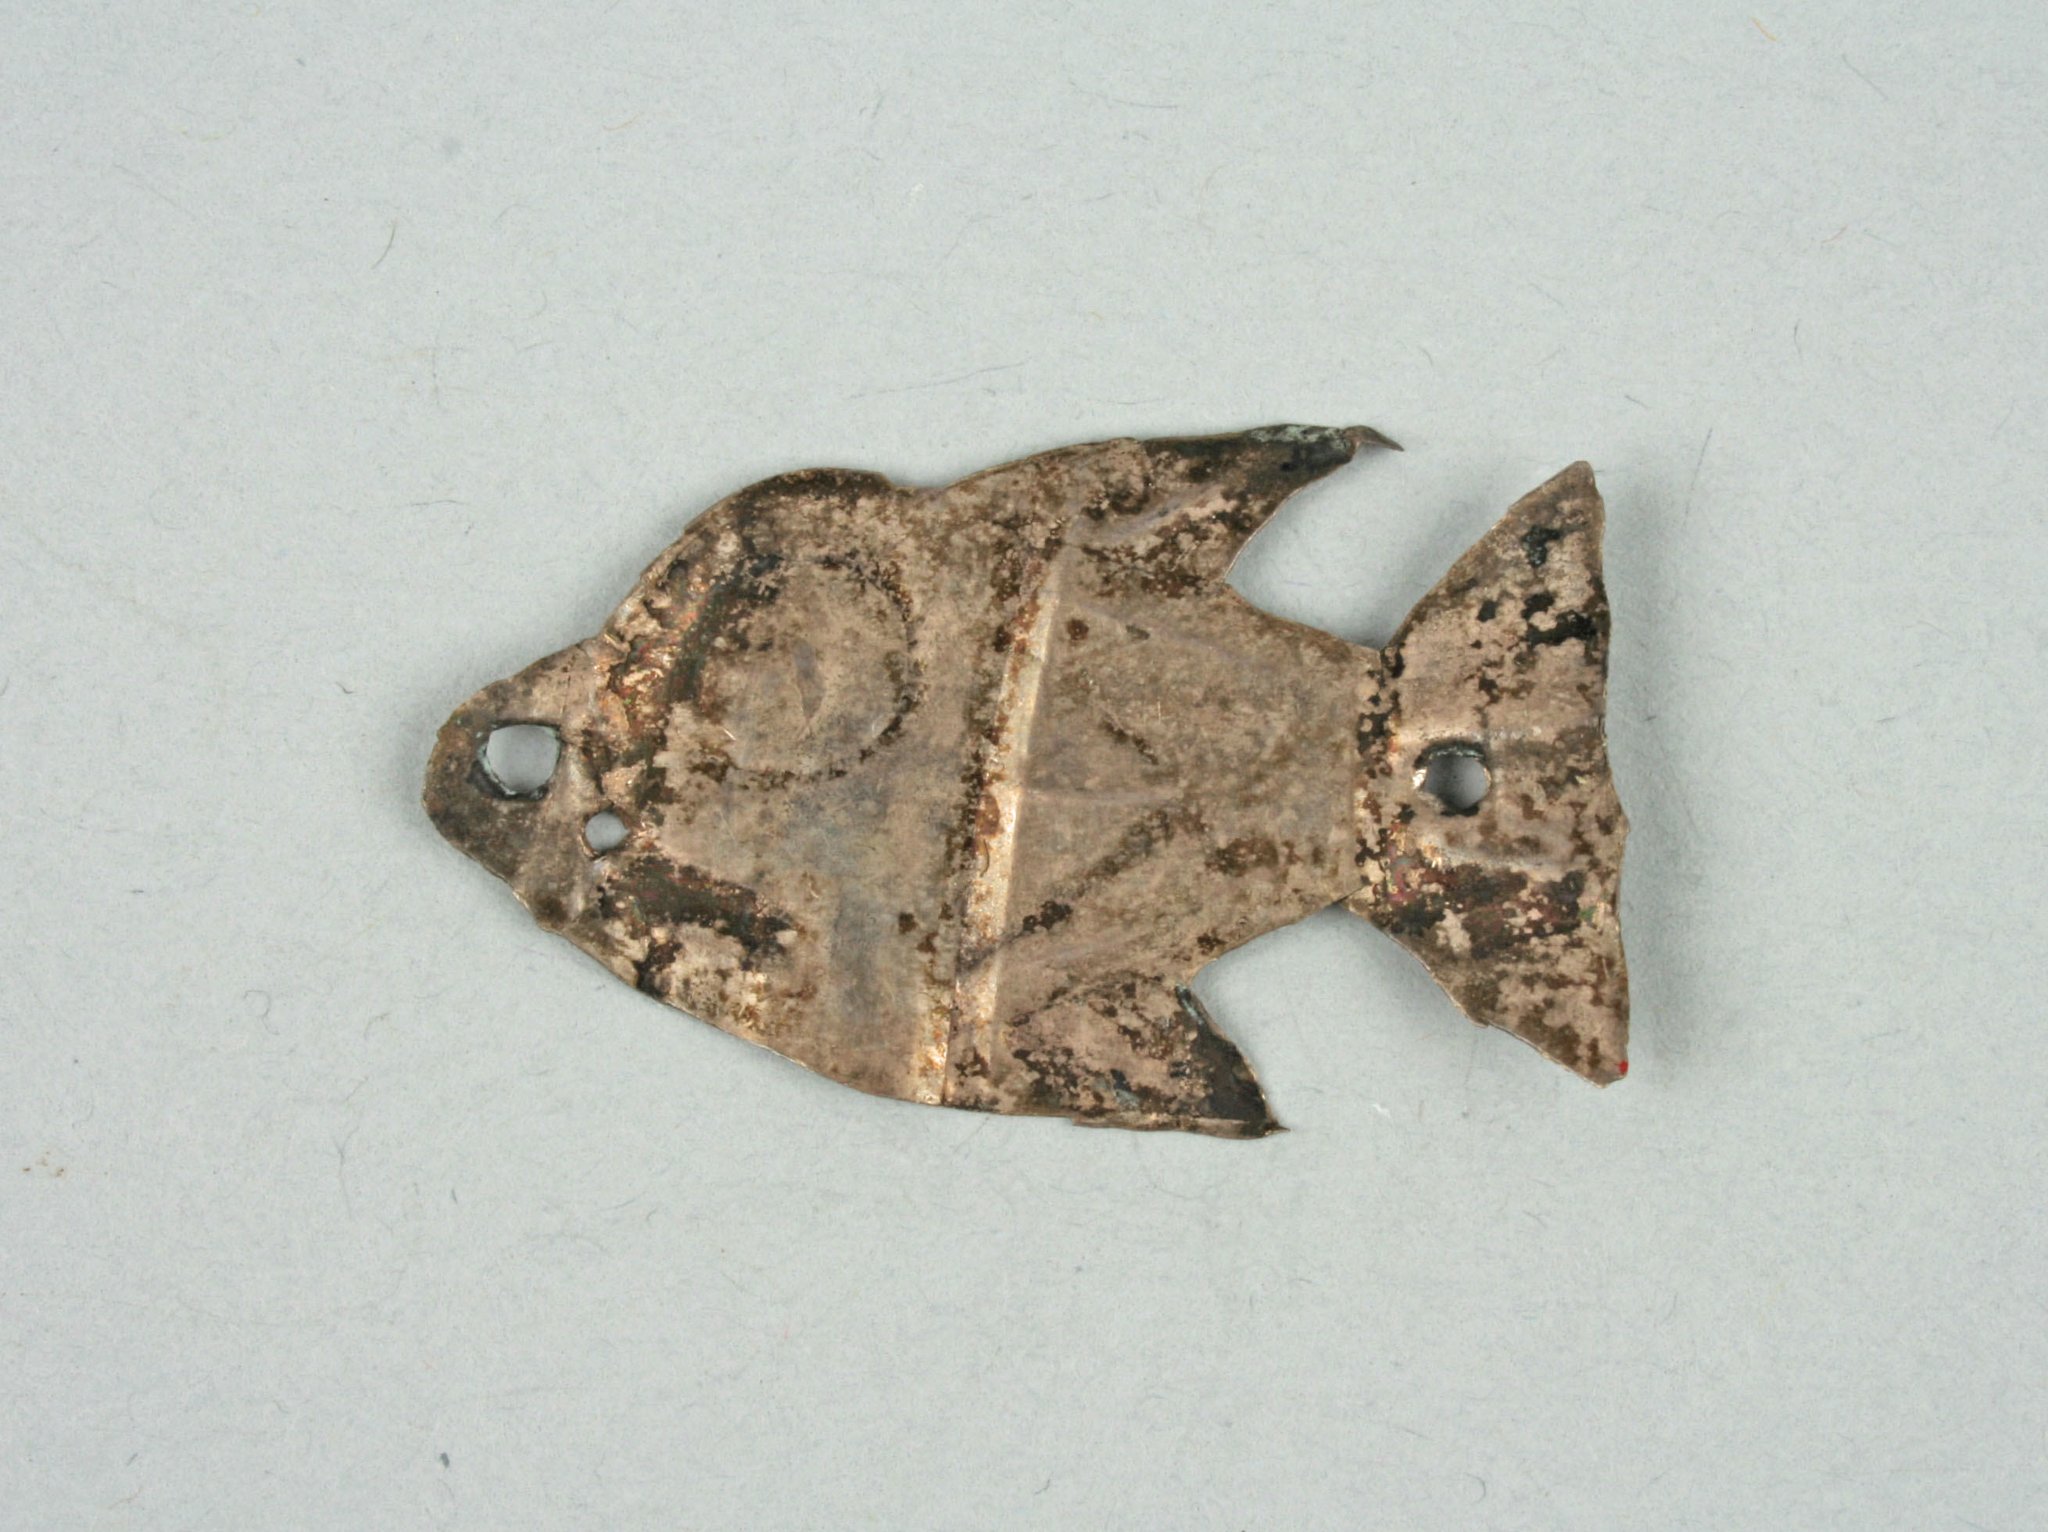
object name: ornament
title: Fish Ornament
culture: peruvian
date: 1001-1200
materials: silver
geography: peru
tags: fish